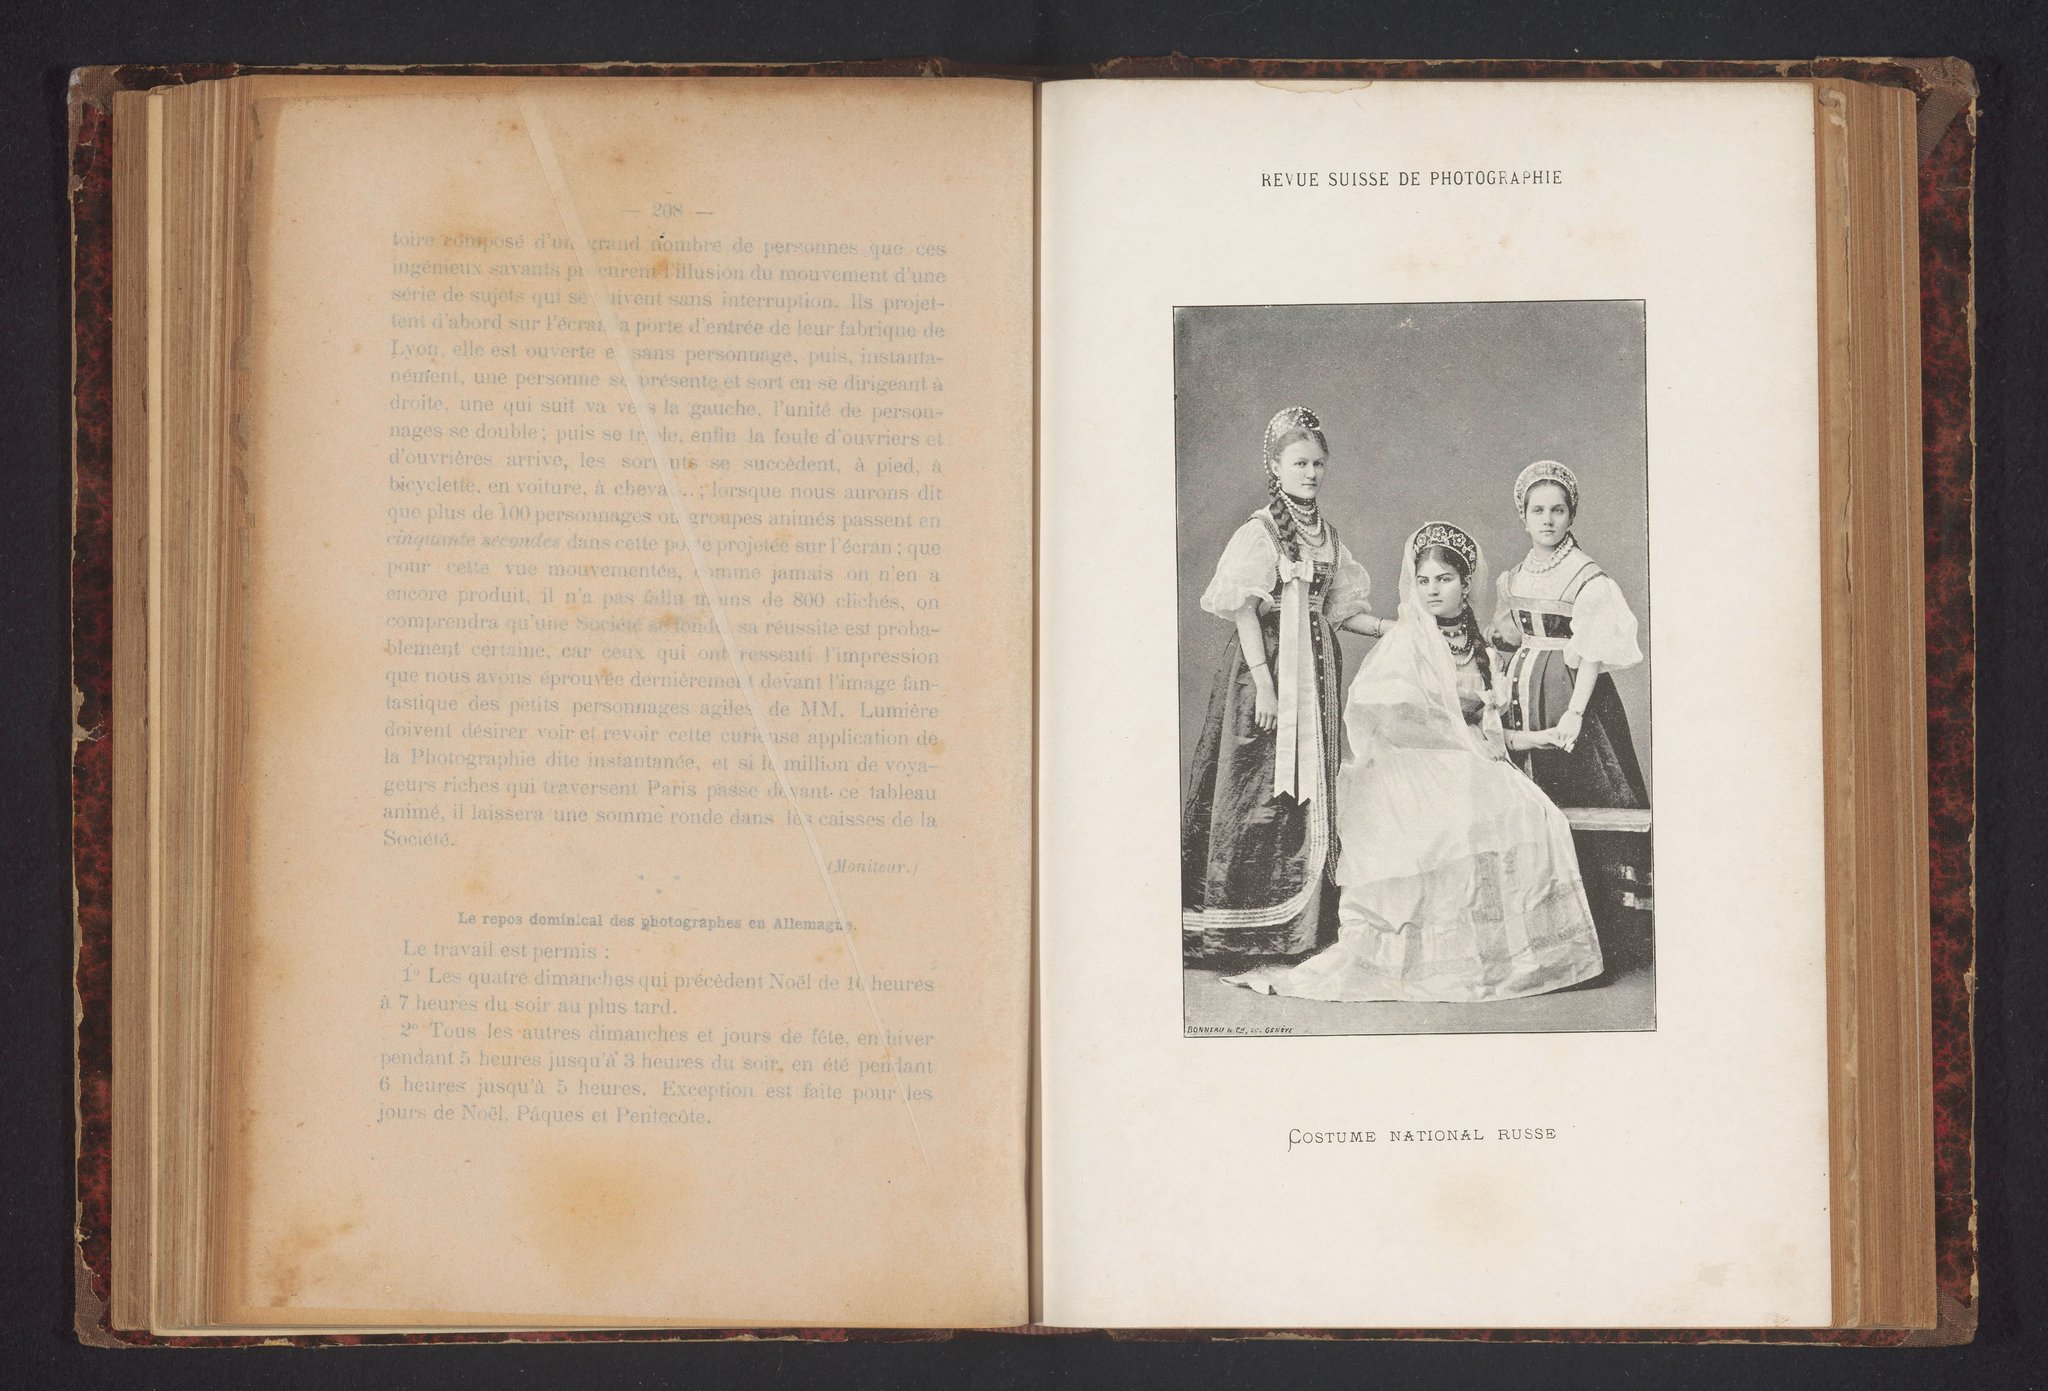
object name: page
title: Costume national Russe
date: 1890-1895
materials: paper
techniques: autotype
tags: adolescent, young woman, maiden, folk costume, regional costume